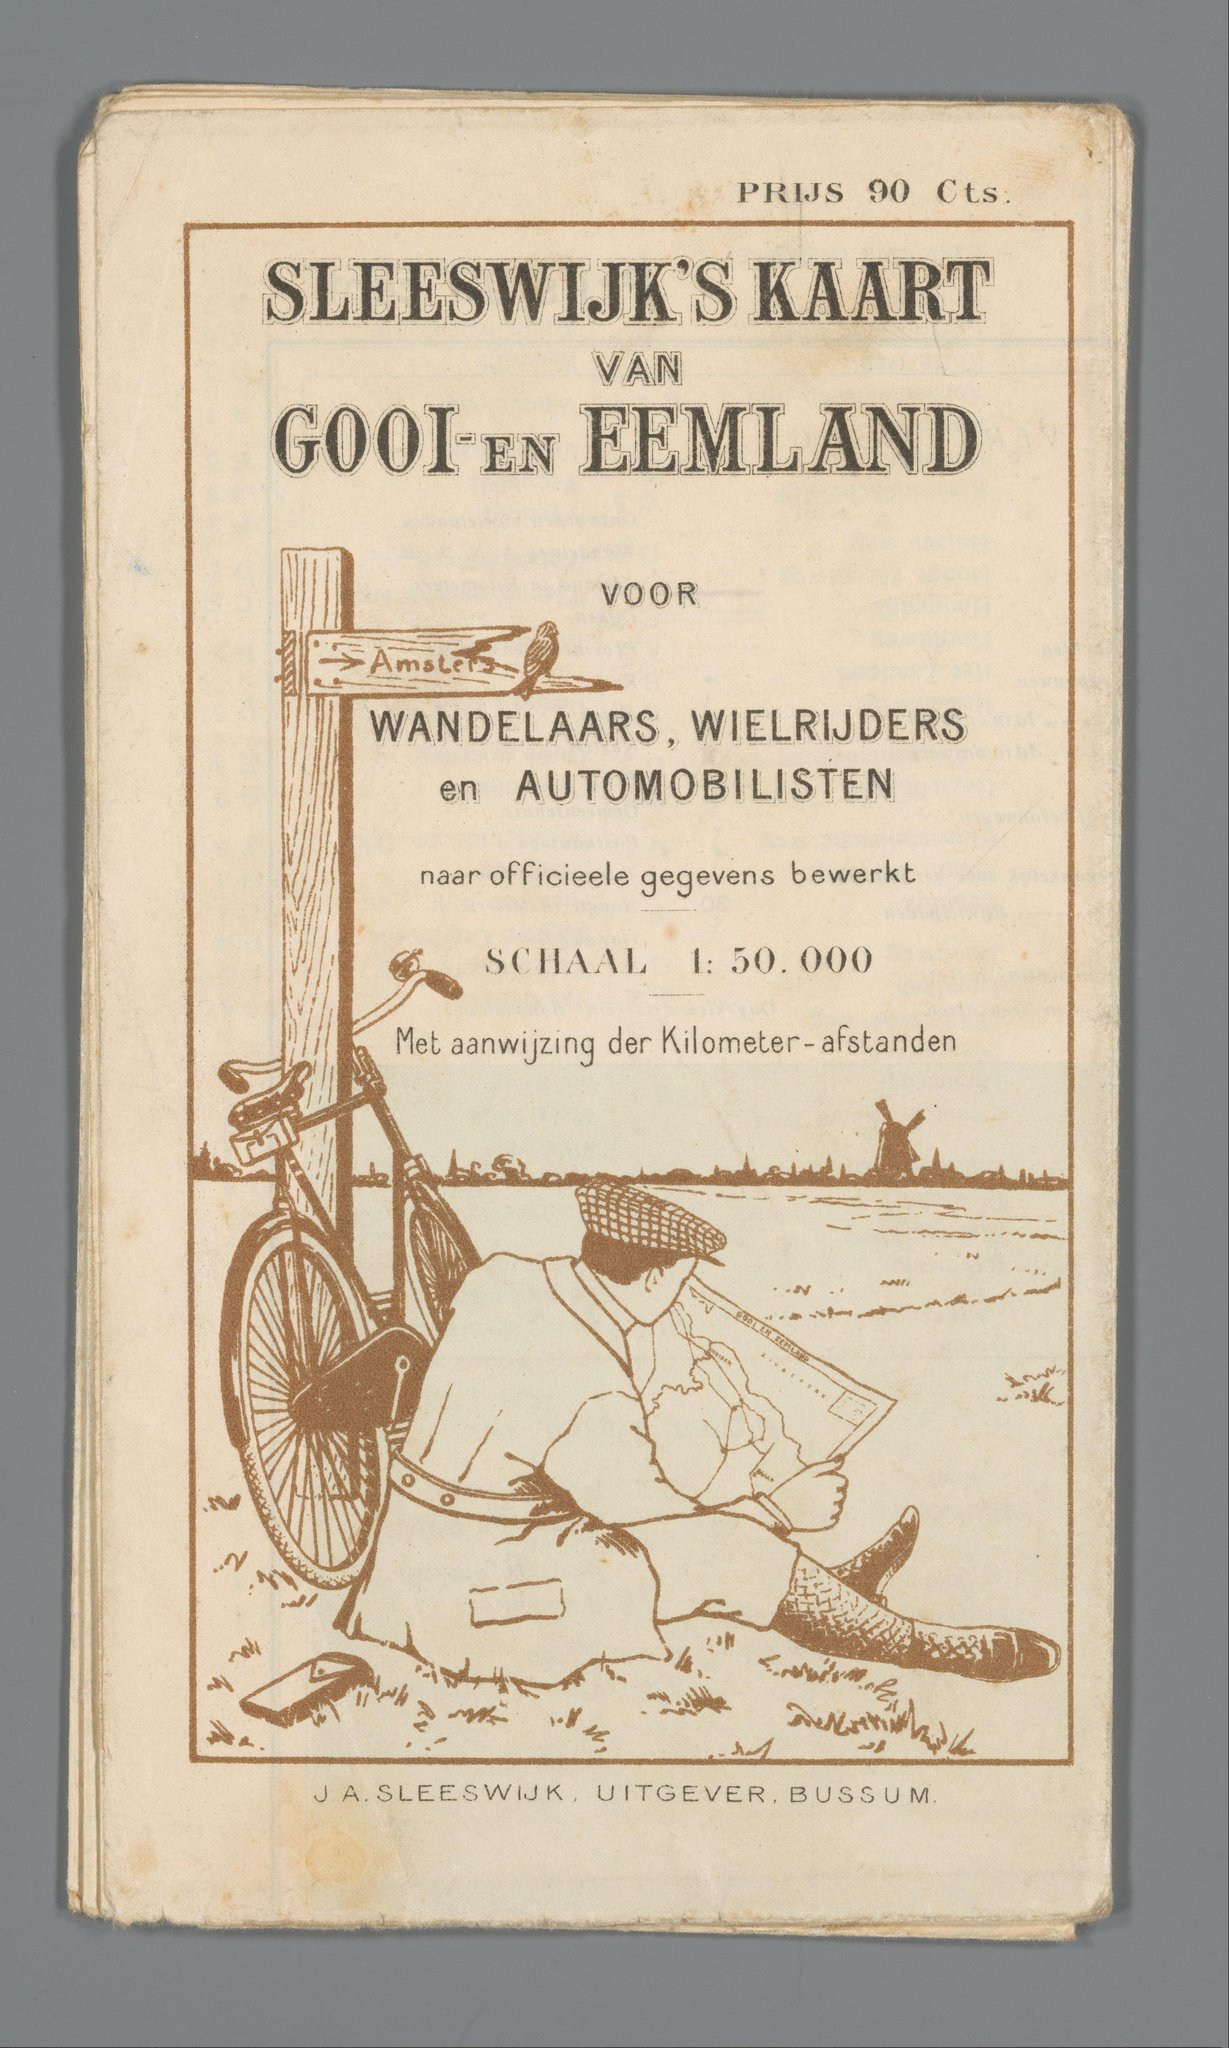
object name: print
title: Kaart van het Gooi en Eemland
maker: j.a. sleeswijk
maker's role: publisher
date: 1930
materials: paper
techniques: lithograph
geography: bussum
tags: maps, atlases